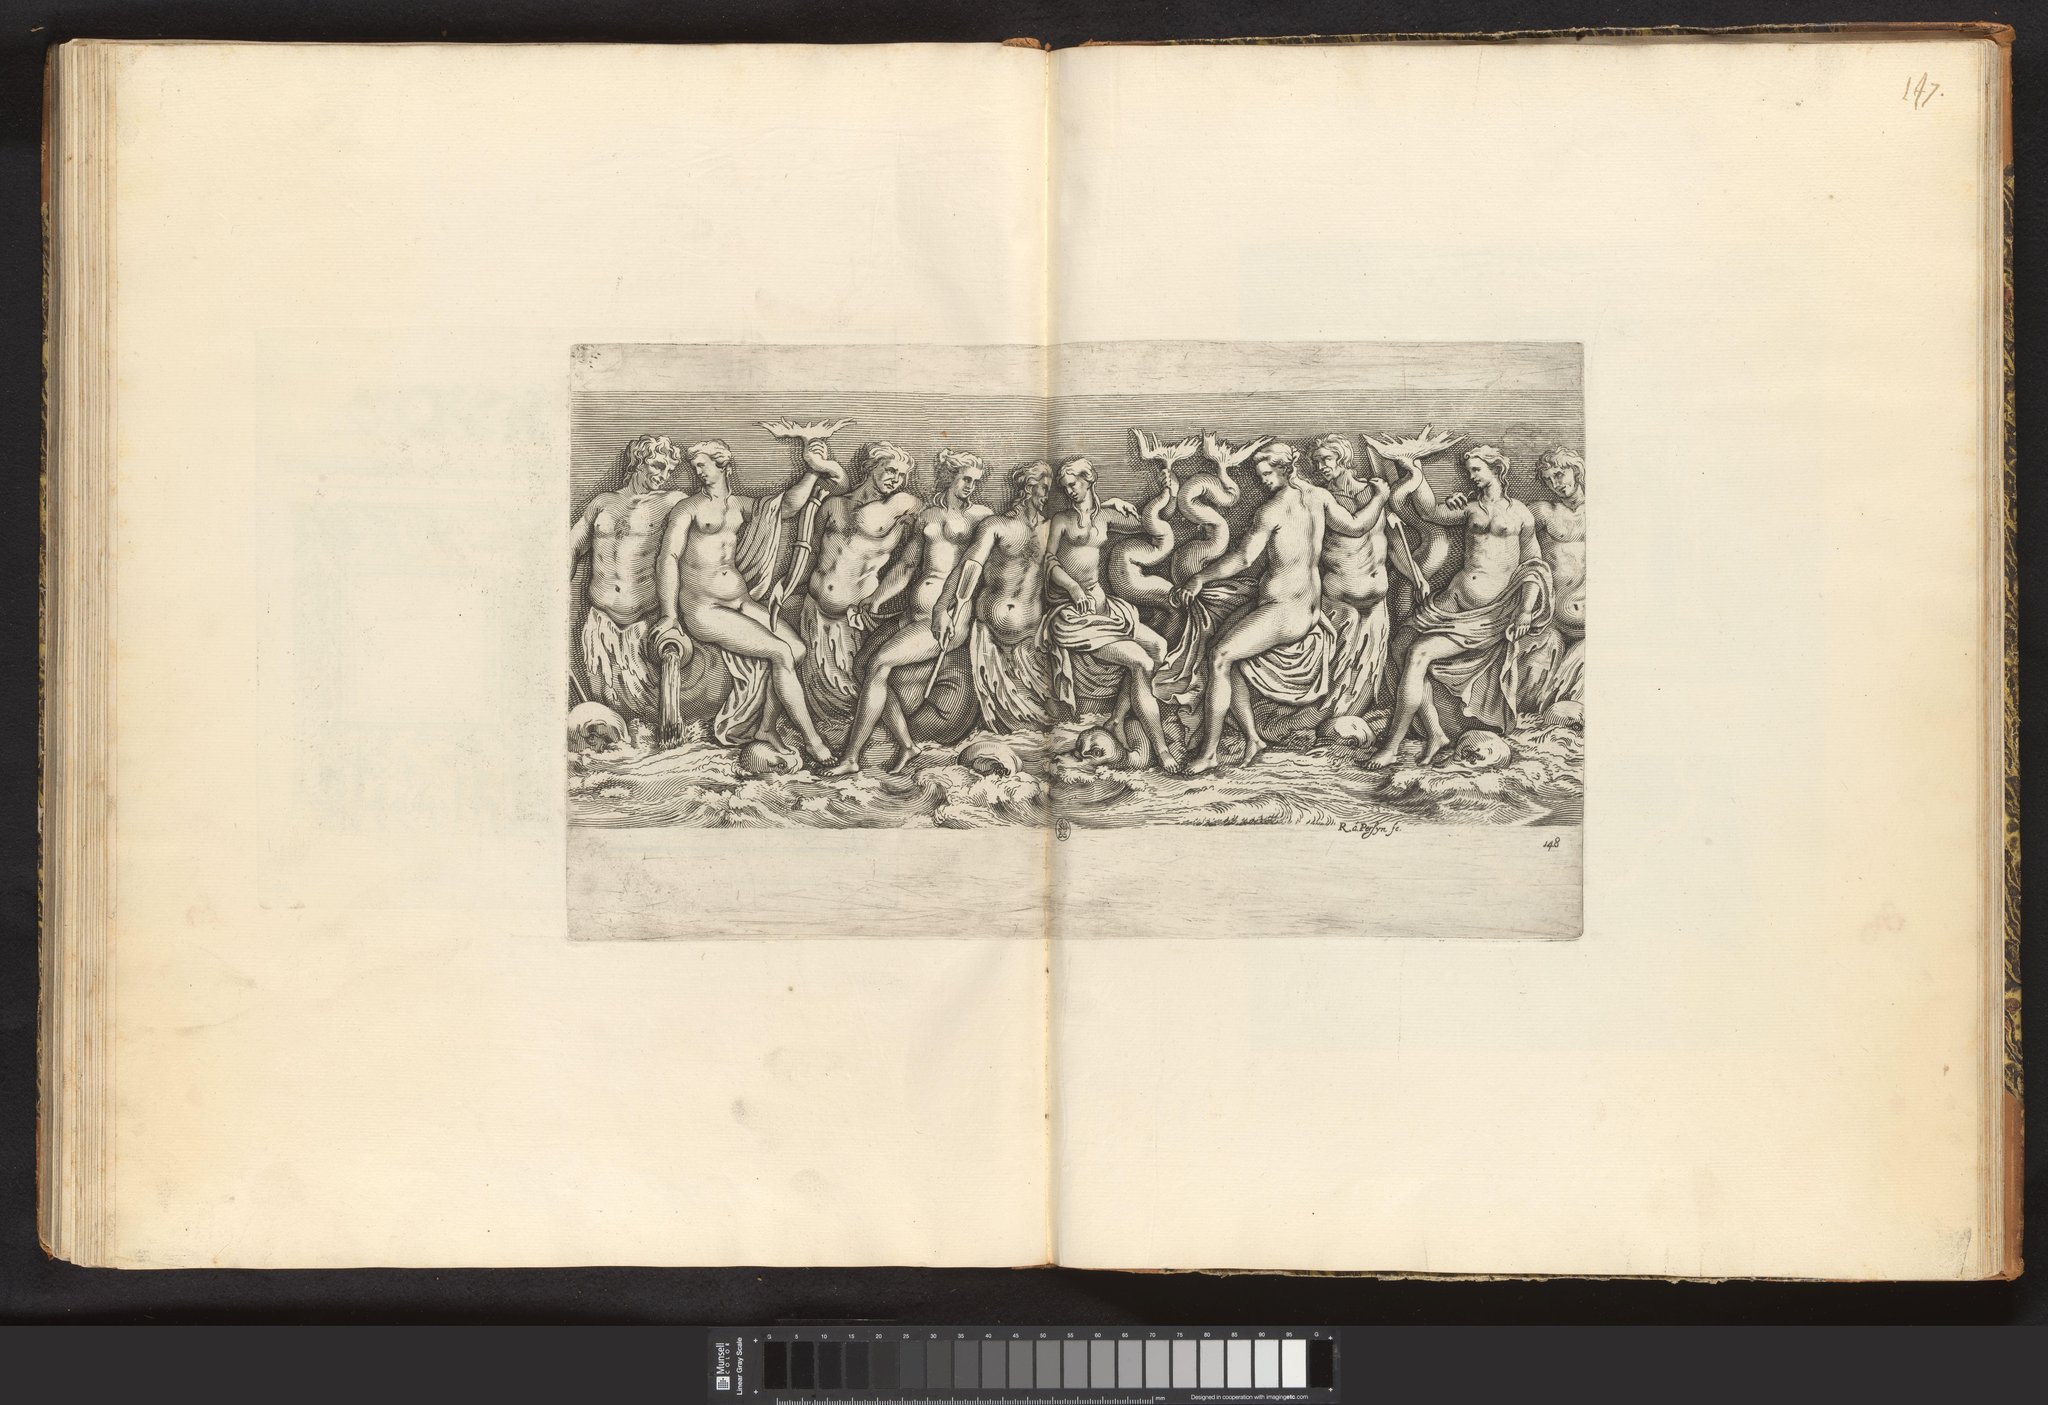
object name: album leaf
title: Galleria Giustiniana del Marchese Vincenzo Giustiniani II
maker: pieter de bailliu (i)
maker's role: print maker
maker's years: 1613-1660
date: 1636-1647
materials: paper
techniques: engraving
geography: rome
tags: piece of sculpture, reproduction of a piece of sculpture, ornament ~ festoon, garland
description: Twee aanzichten van een piëdestal. Op beide een ramskoppen met aan de hoorns een guirlande. Midden onder op de basis van het piëdestal het wapenschild van Vincenzo Giustiniani. Prent maakt deel uit van een album met een serie prenten naar de sculpturen in de verzameling in de Galleria Giustiniani te Rome.